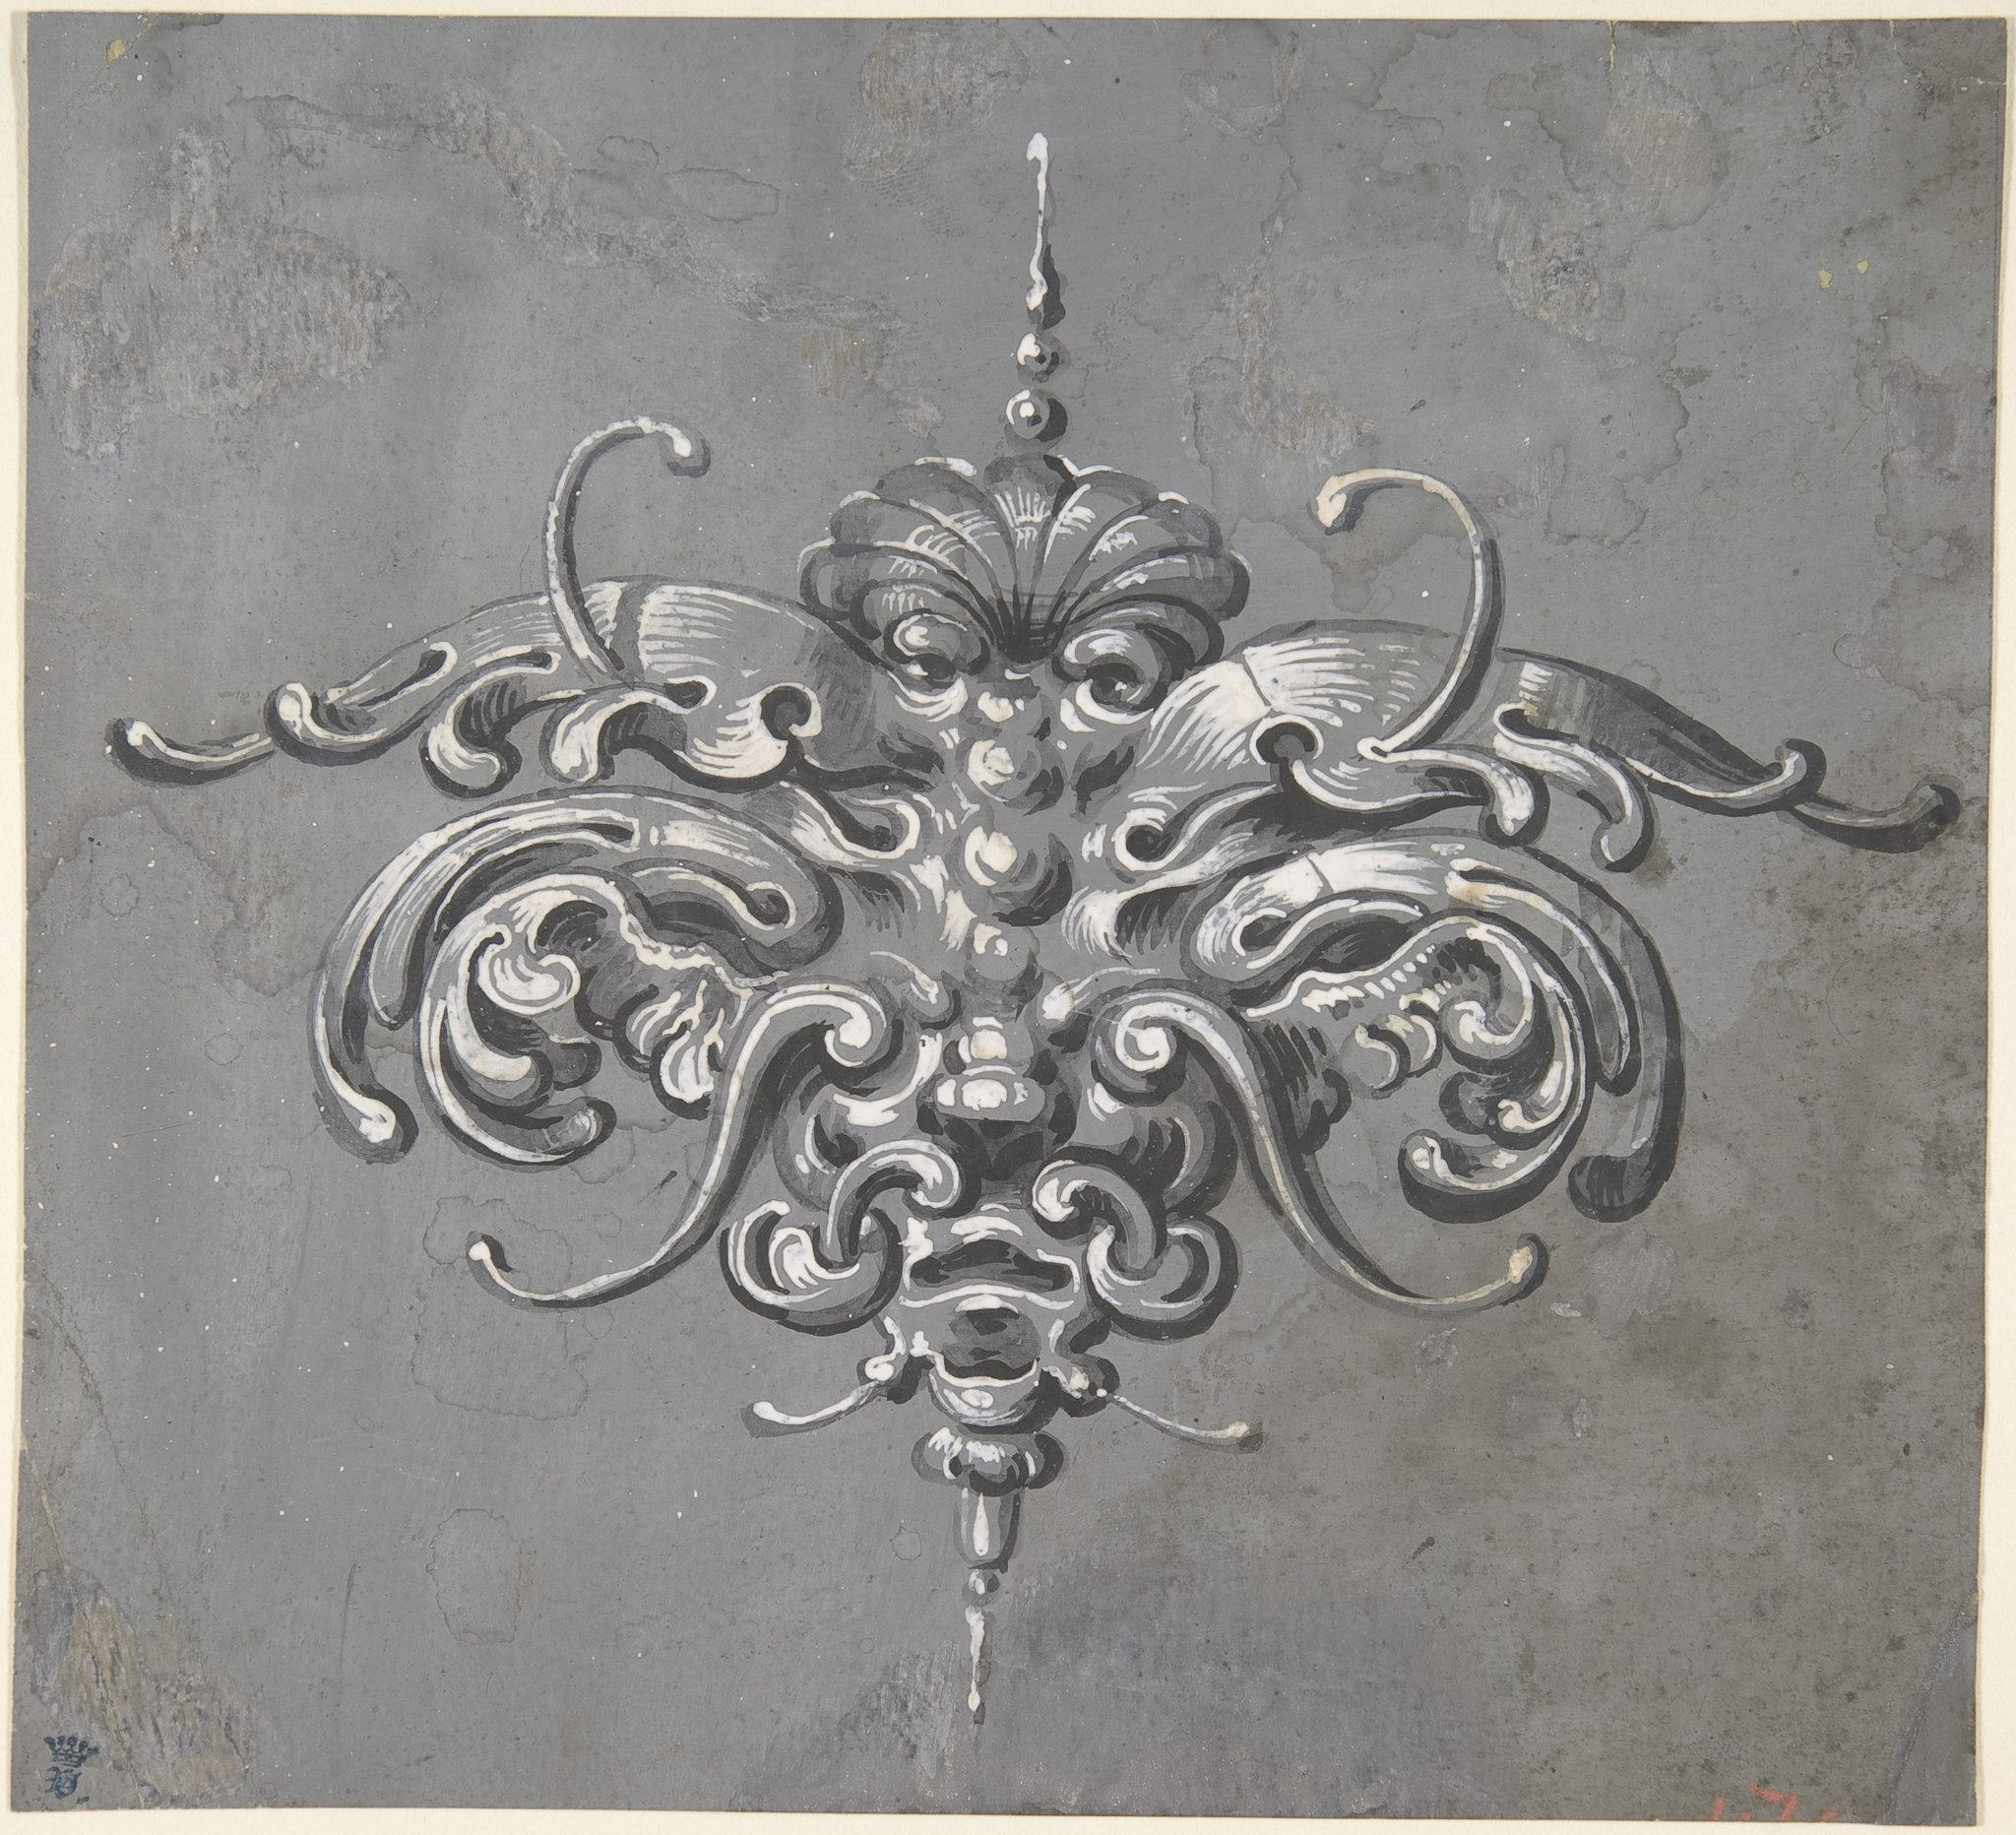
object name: ornament architecture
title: Ornament Design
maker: anonymous, german, 17th century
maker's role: artist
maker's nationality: german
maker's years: 1600-1700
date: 1601-1700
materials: gouache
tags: ornament